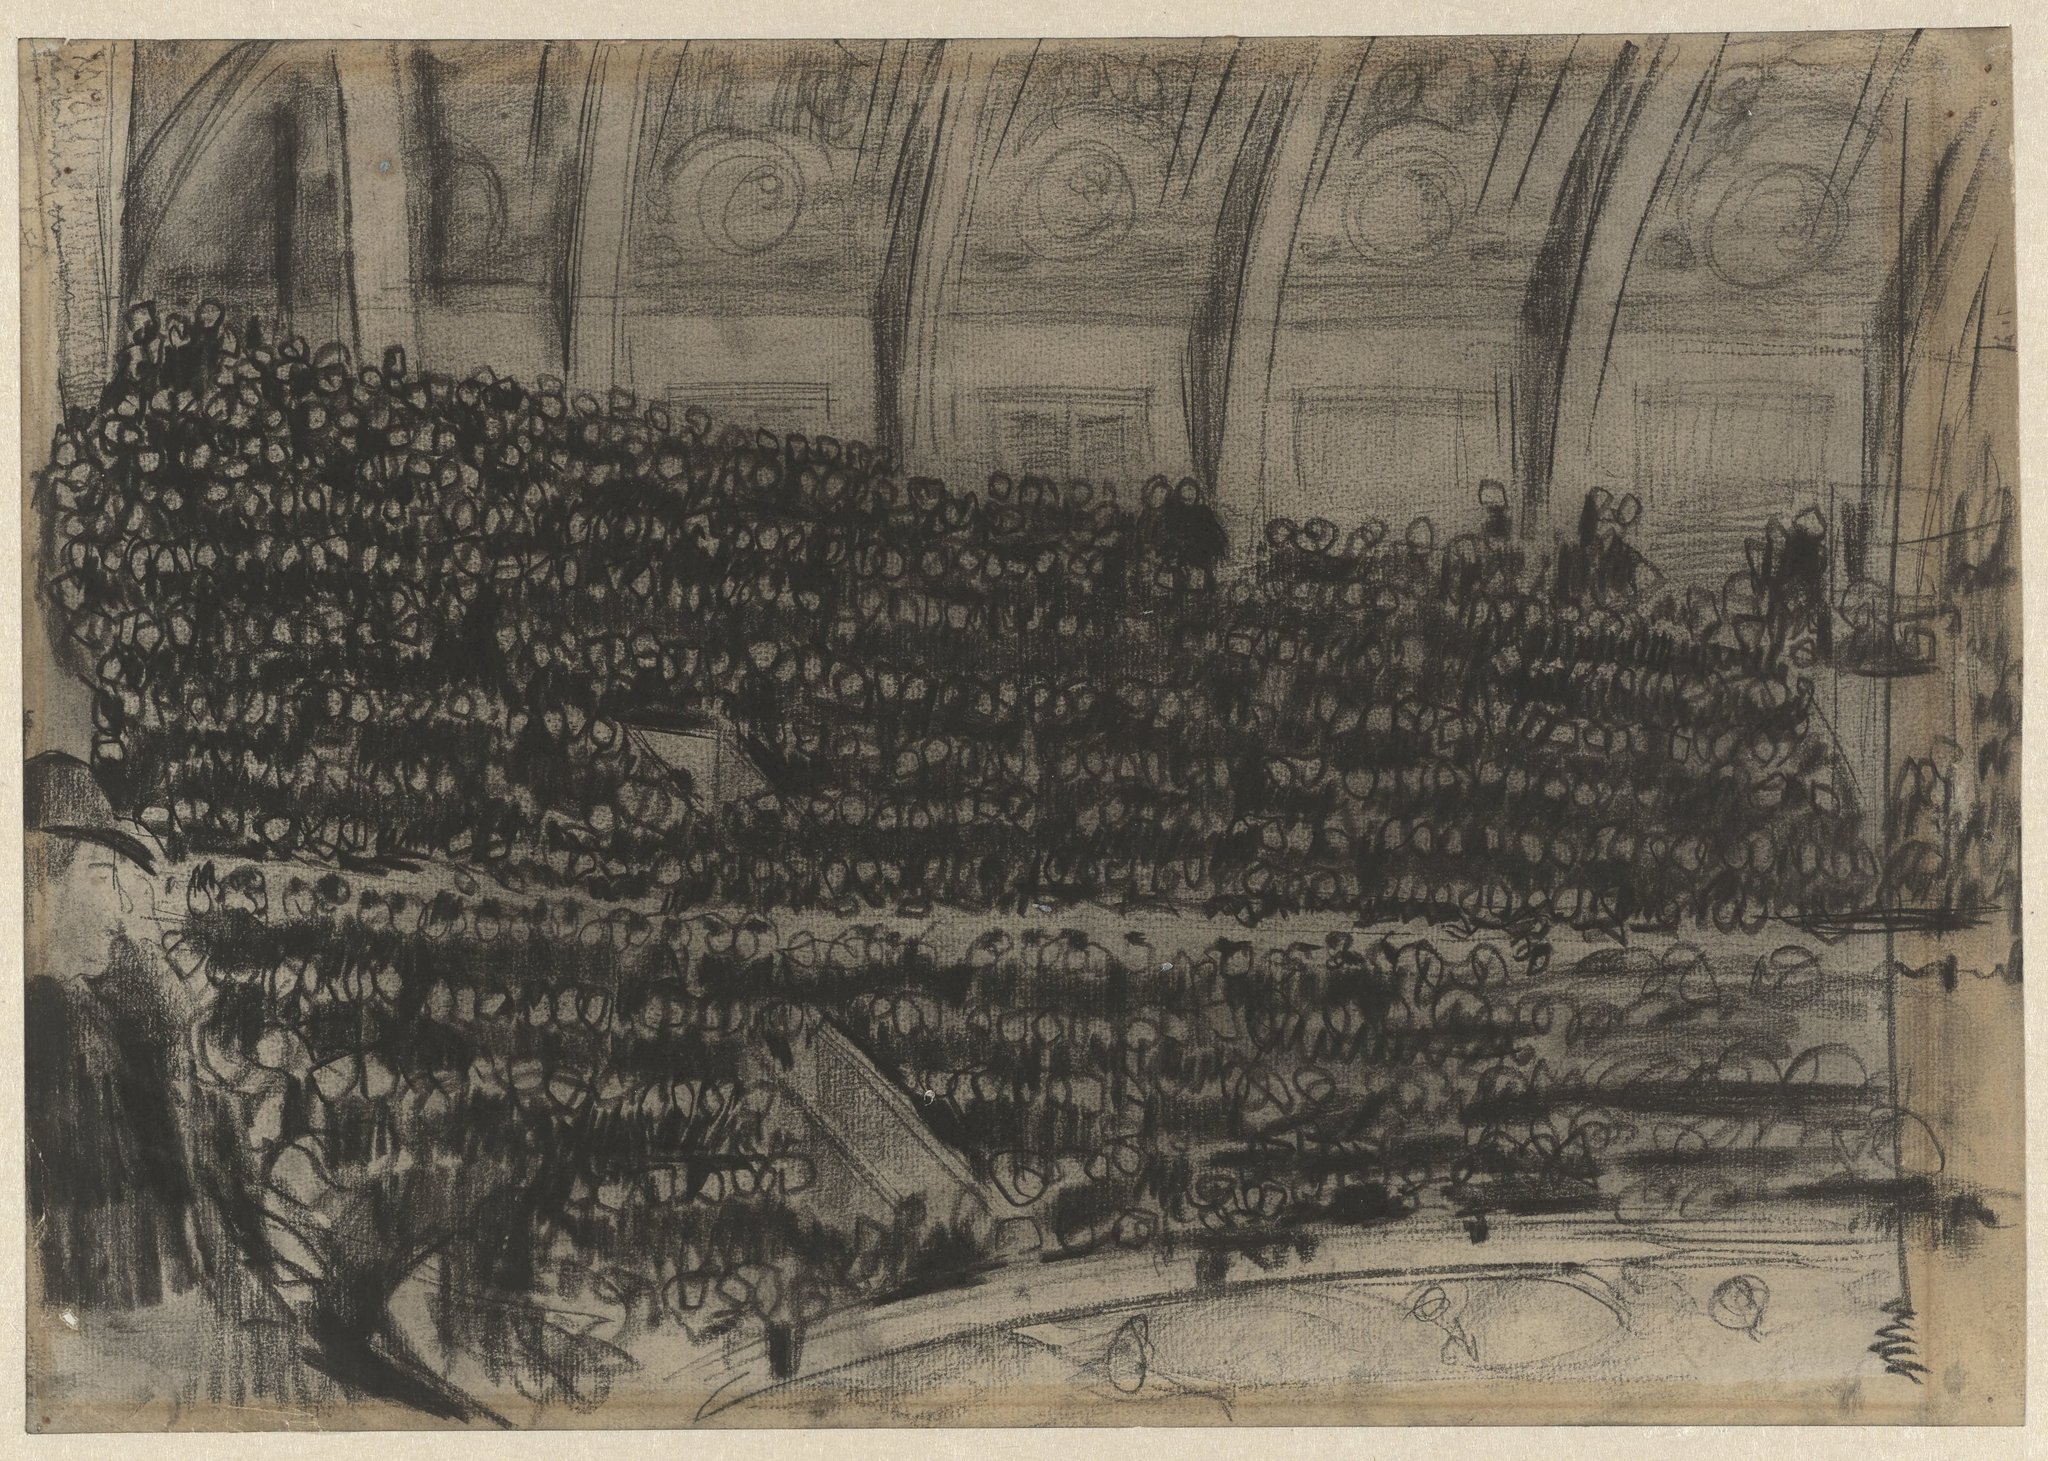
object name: drawing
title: Toeschouwers op de tribunes van Circus Carré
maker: gerrit willem dijsselhof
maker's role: designer, draughtsman, print maker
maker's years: 1866-1924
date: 1876-1924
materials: chalk, paper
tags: circus (+ the public ~ festive activities), names of organizations, companies, trade unions, etc.